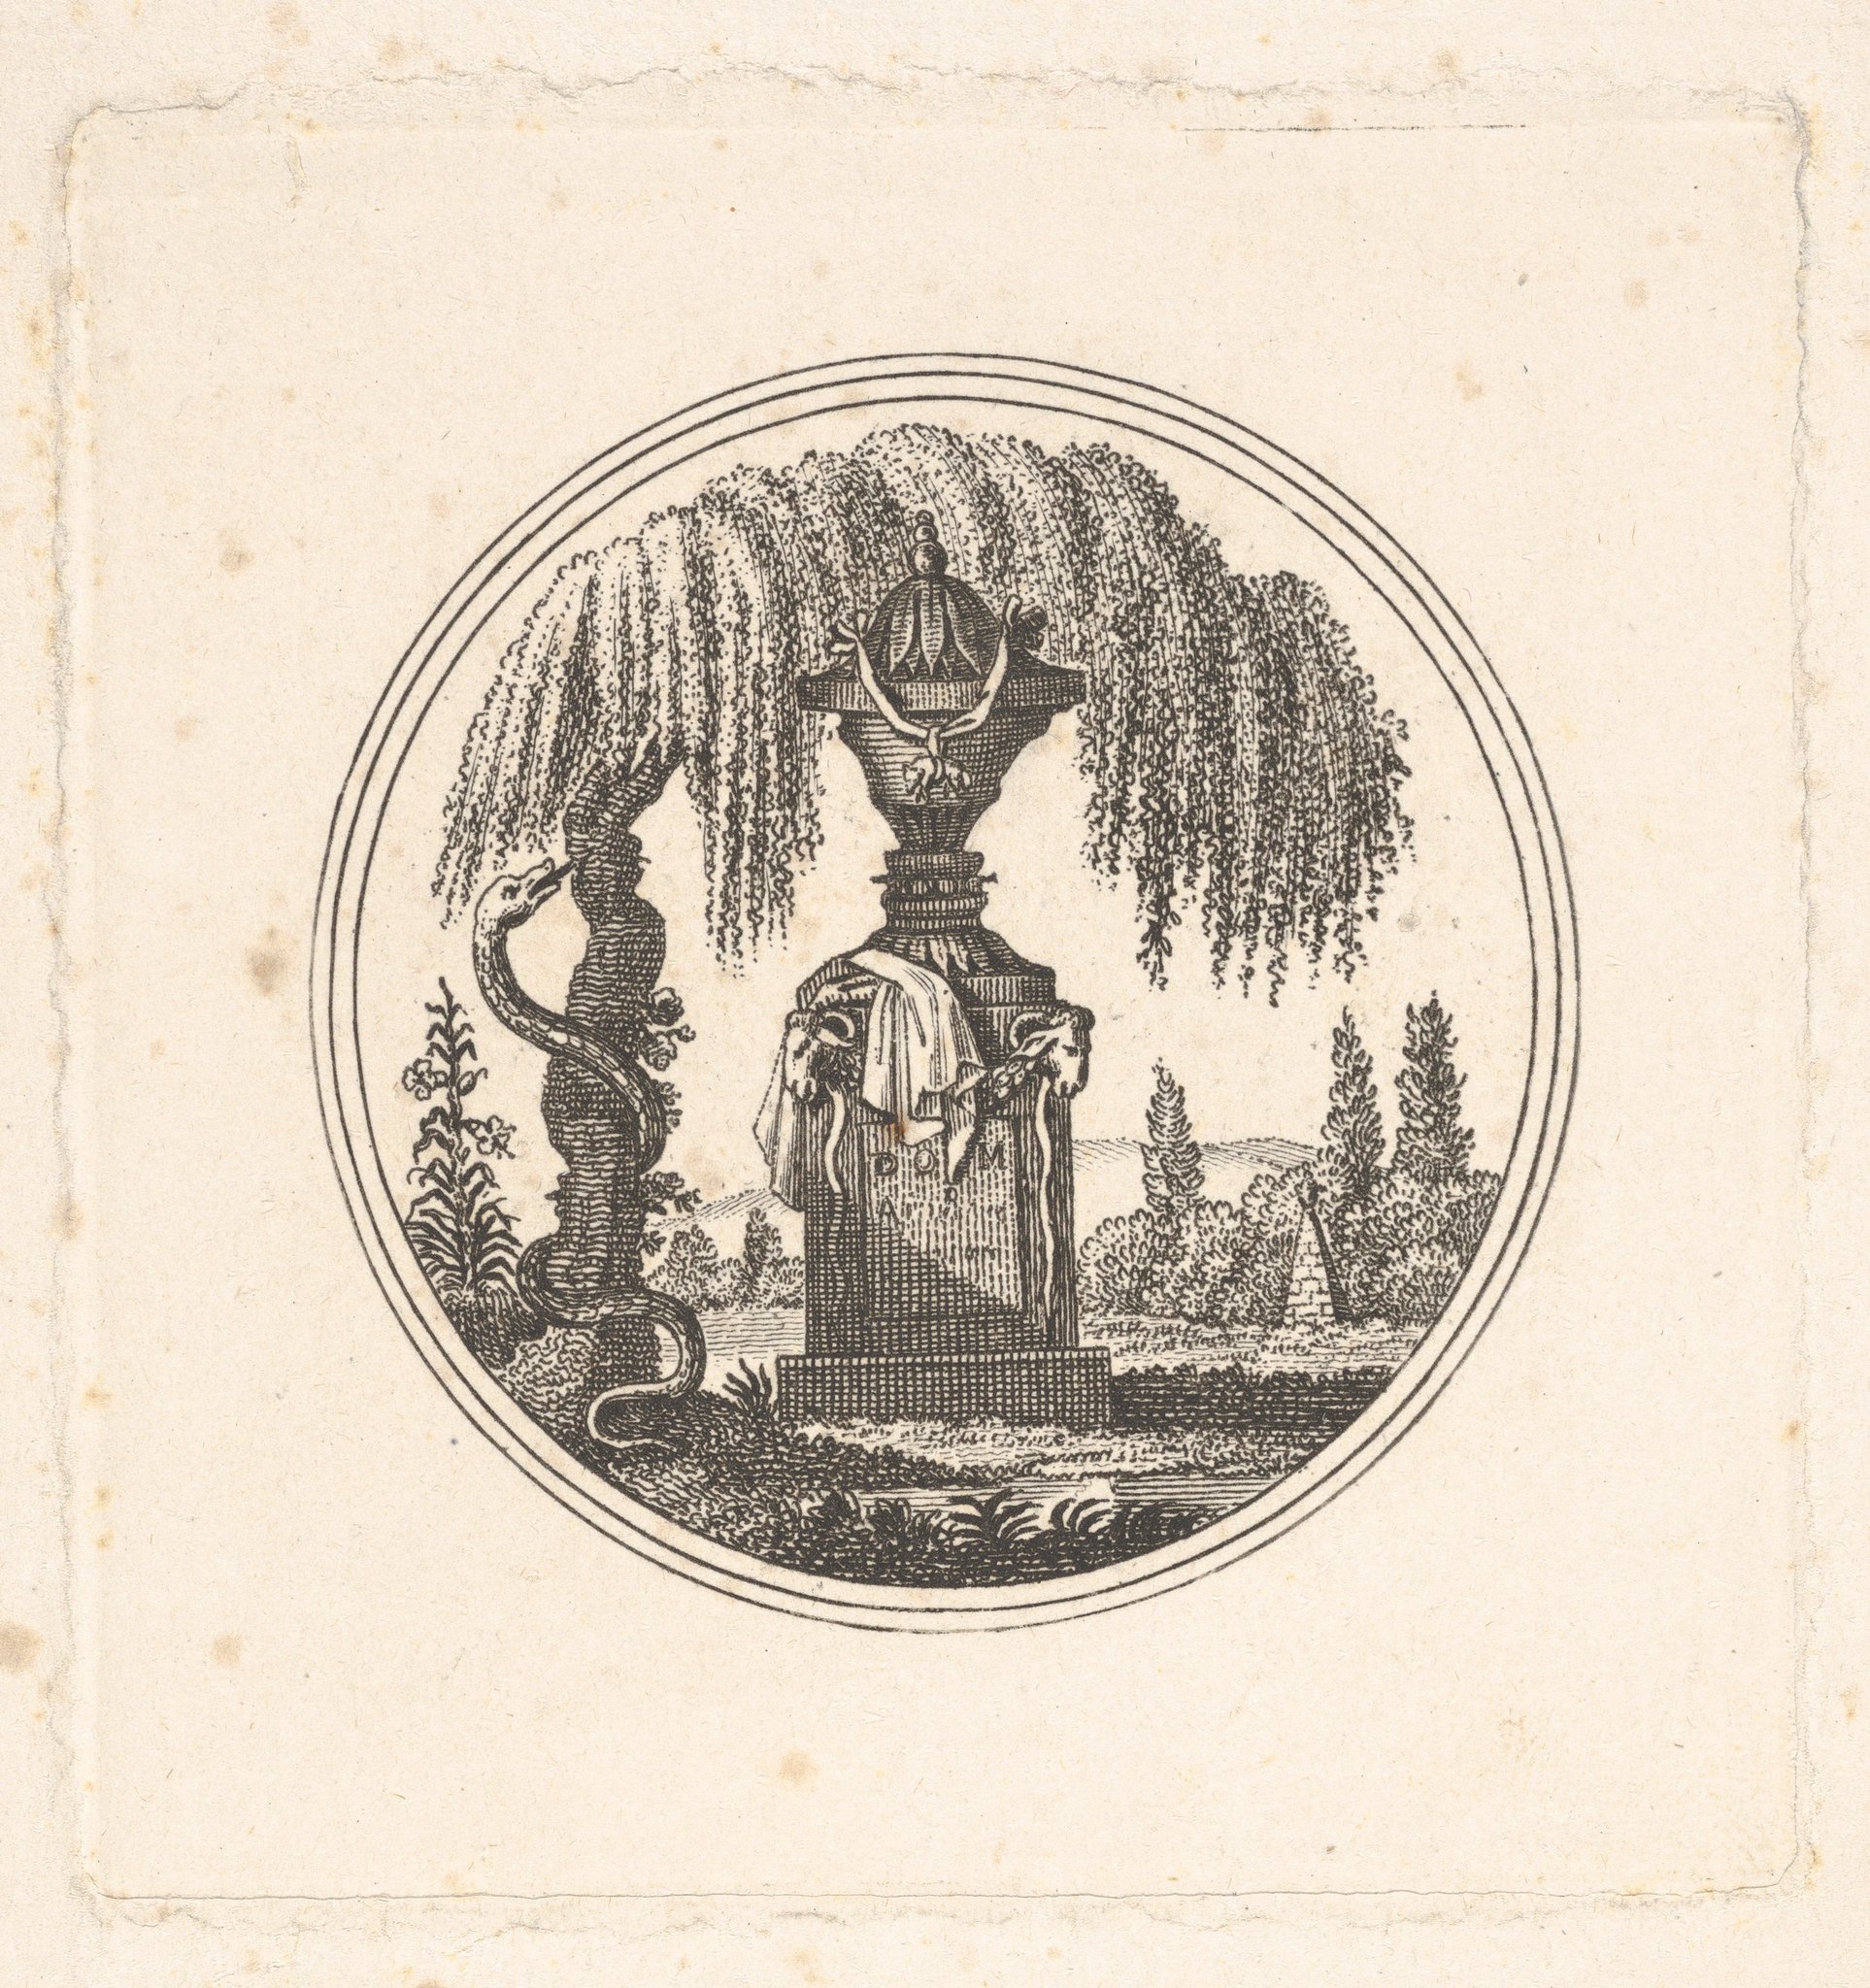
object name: print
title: Royalist trompe l'oeil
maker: anonymous, french, 18th century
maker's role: artist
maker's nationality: french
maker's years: 1700-1800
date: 1701-1800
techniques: engraving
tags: serpents,vases